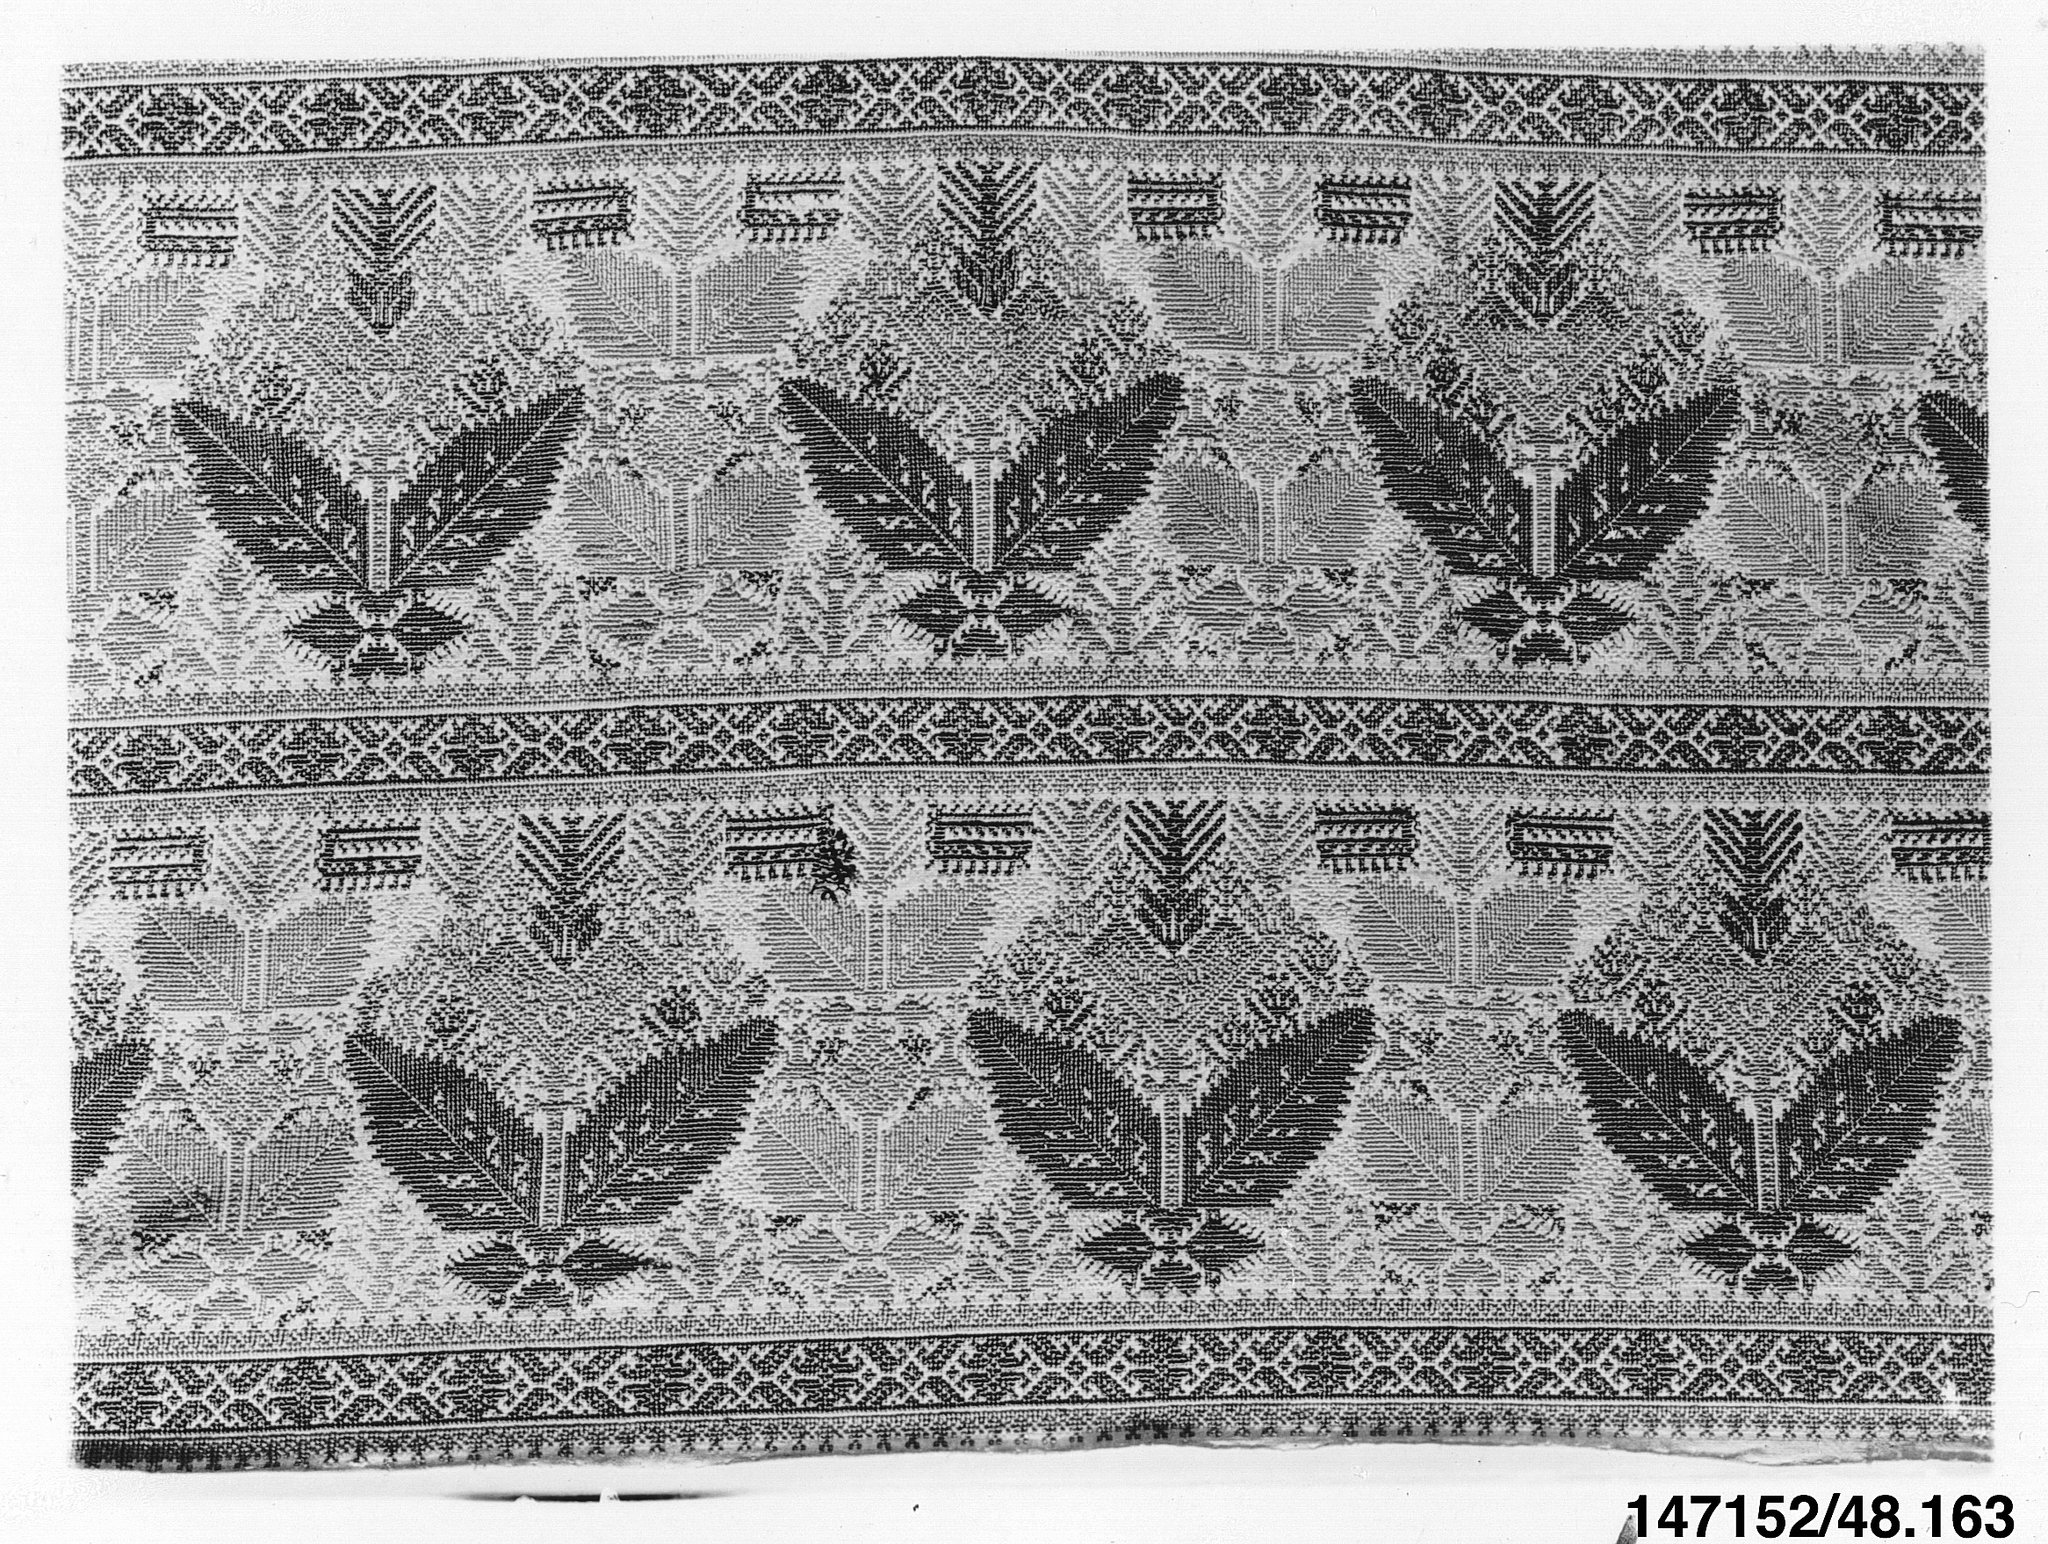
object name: bed curtain fragment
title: Part of a bed curtain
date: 1701-1800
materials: linen, silk